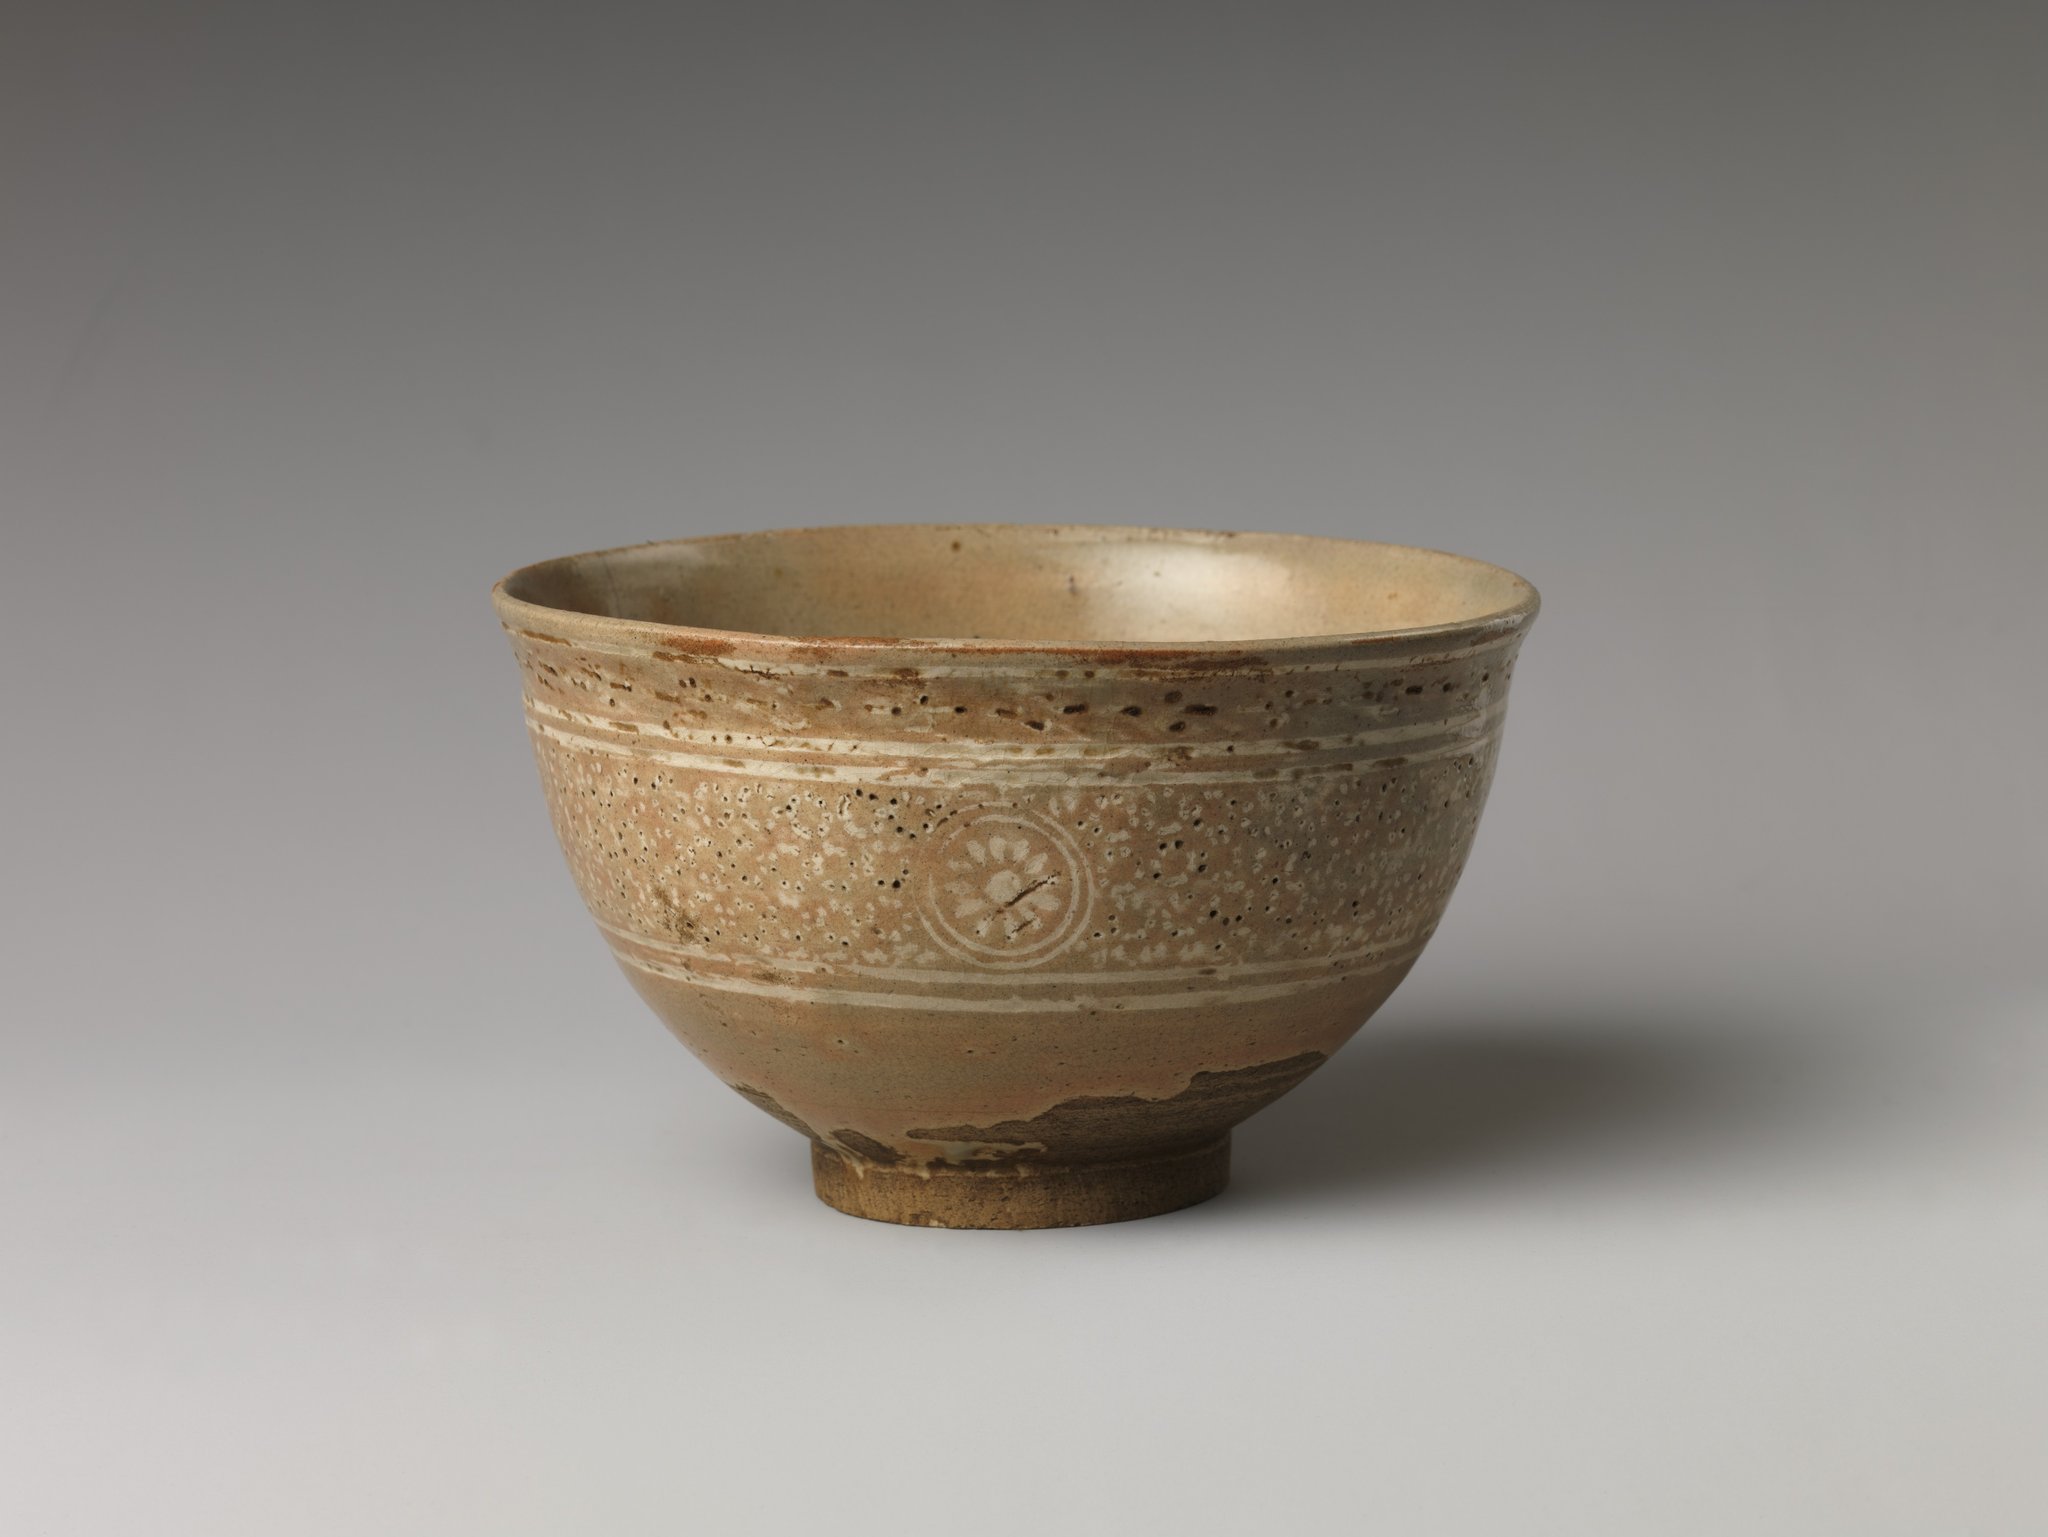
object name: teabowl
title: Tea Bowl with Chrysanthemum Decoration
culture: japanese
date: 1651-1700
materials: stoneware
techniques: inlay, stamping